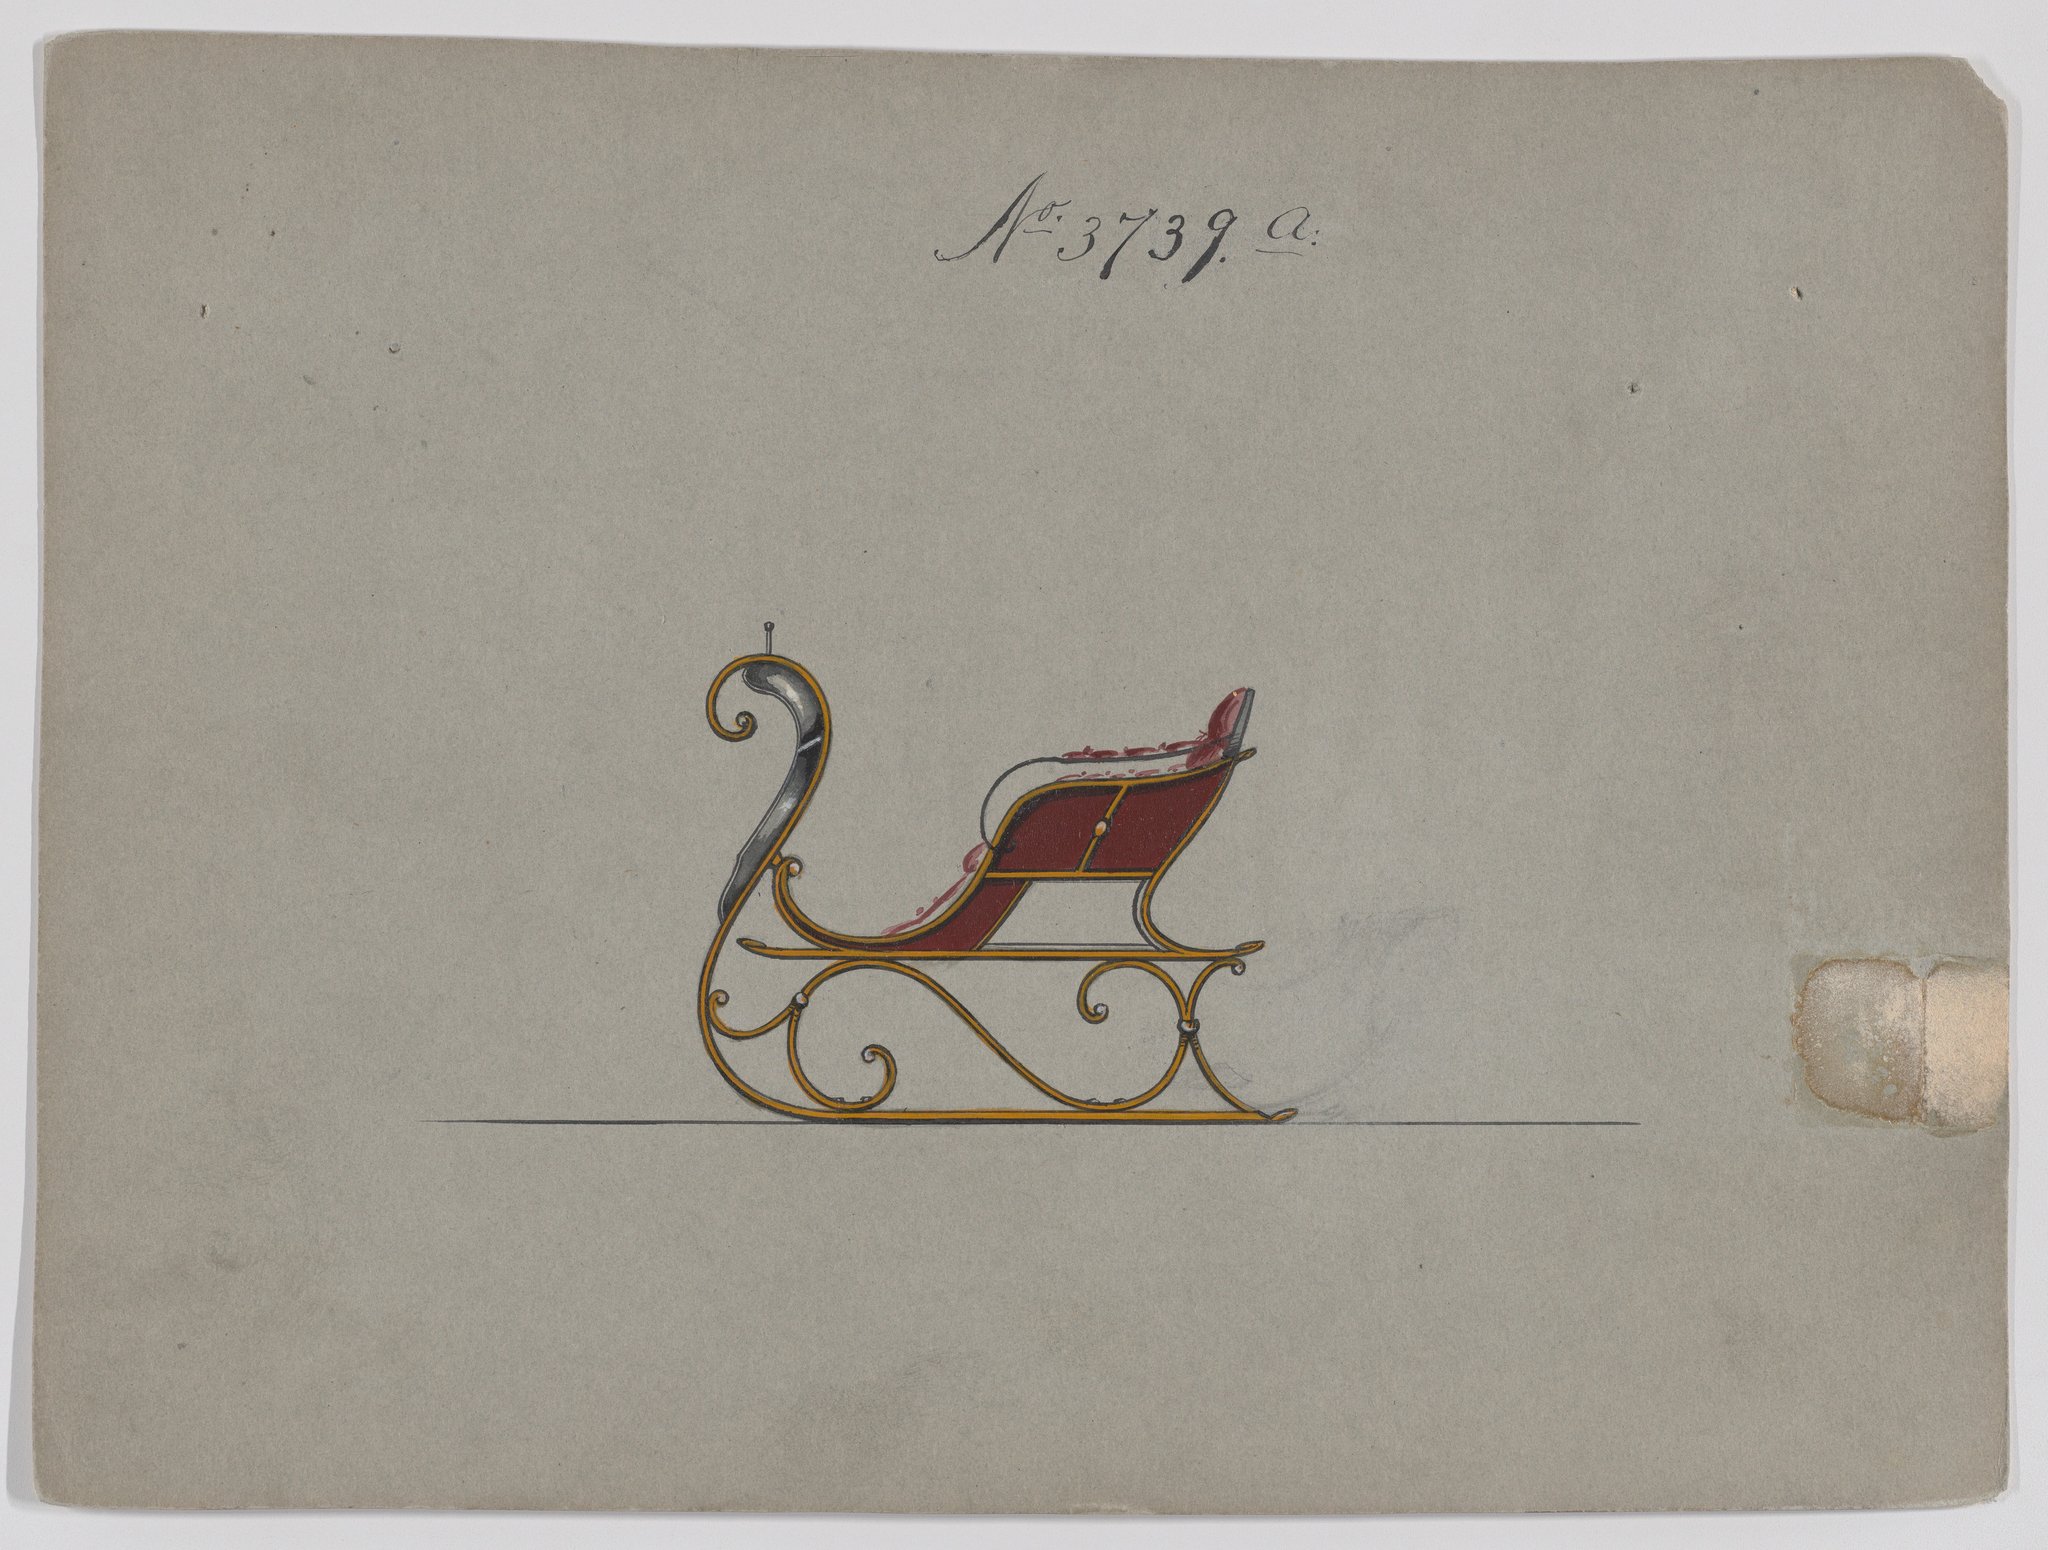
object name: drawing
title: Sleigh #3739a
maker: brewster & co.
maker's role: manufacturer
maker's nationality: american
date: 1882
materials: gouache, graphite, ink, watercolor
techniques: pen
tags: sleighs